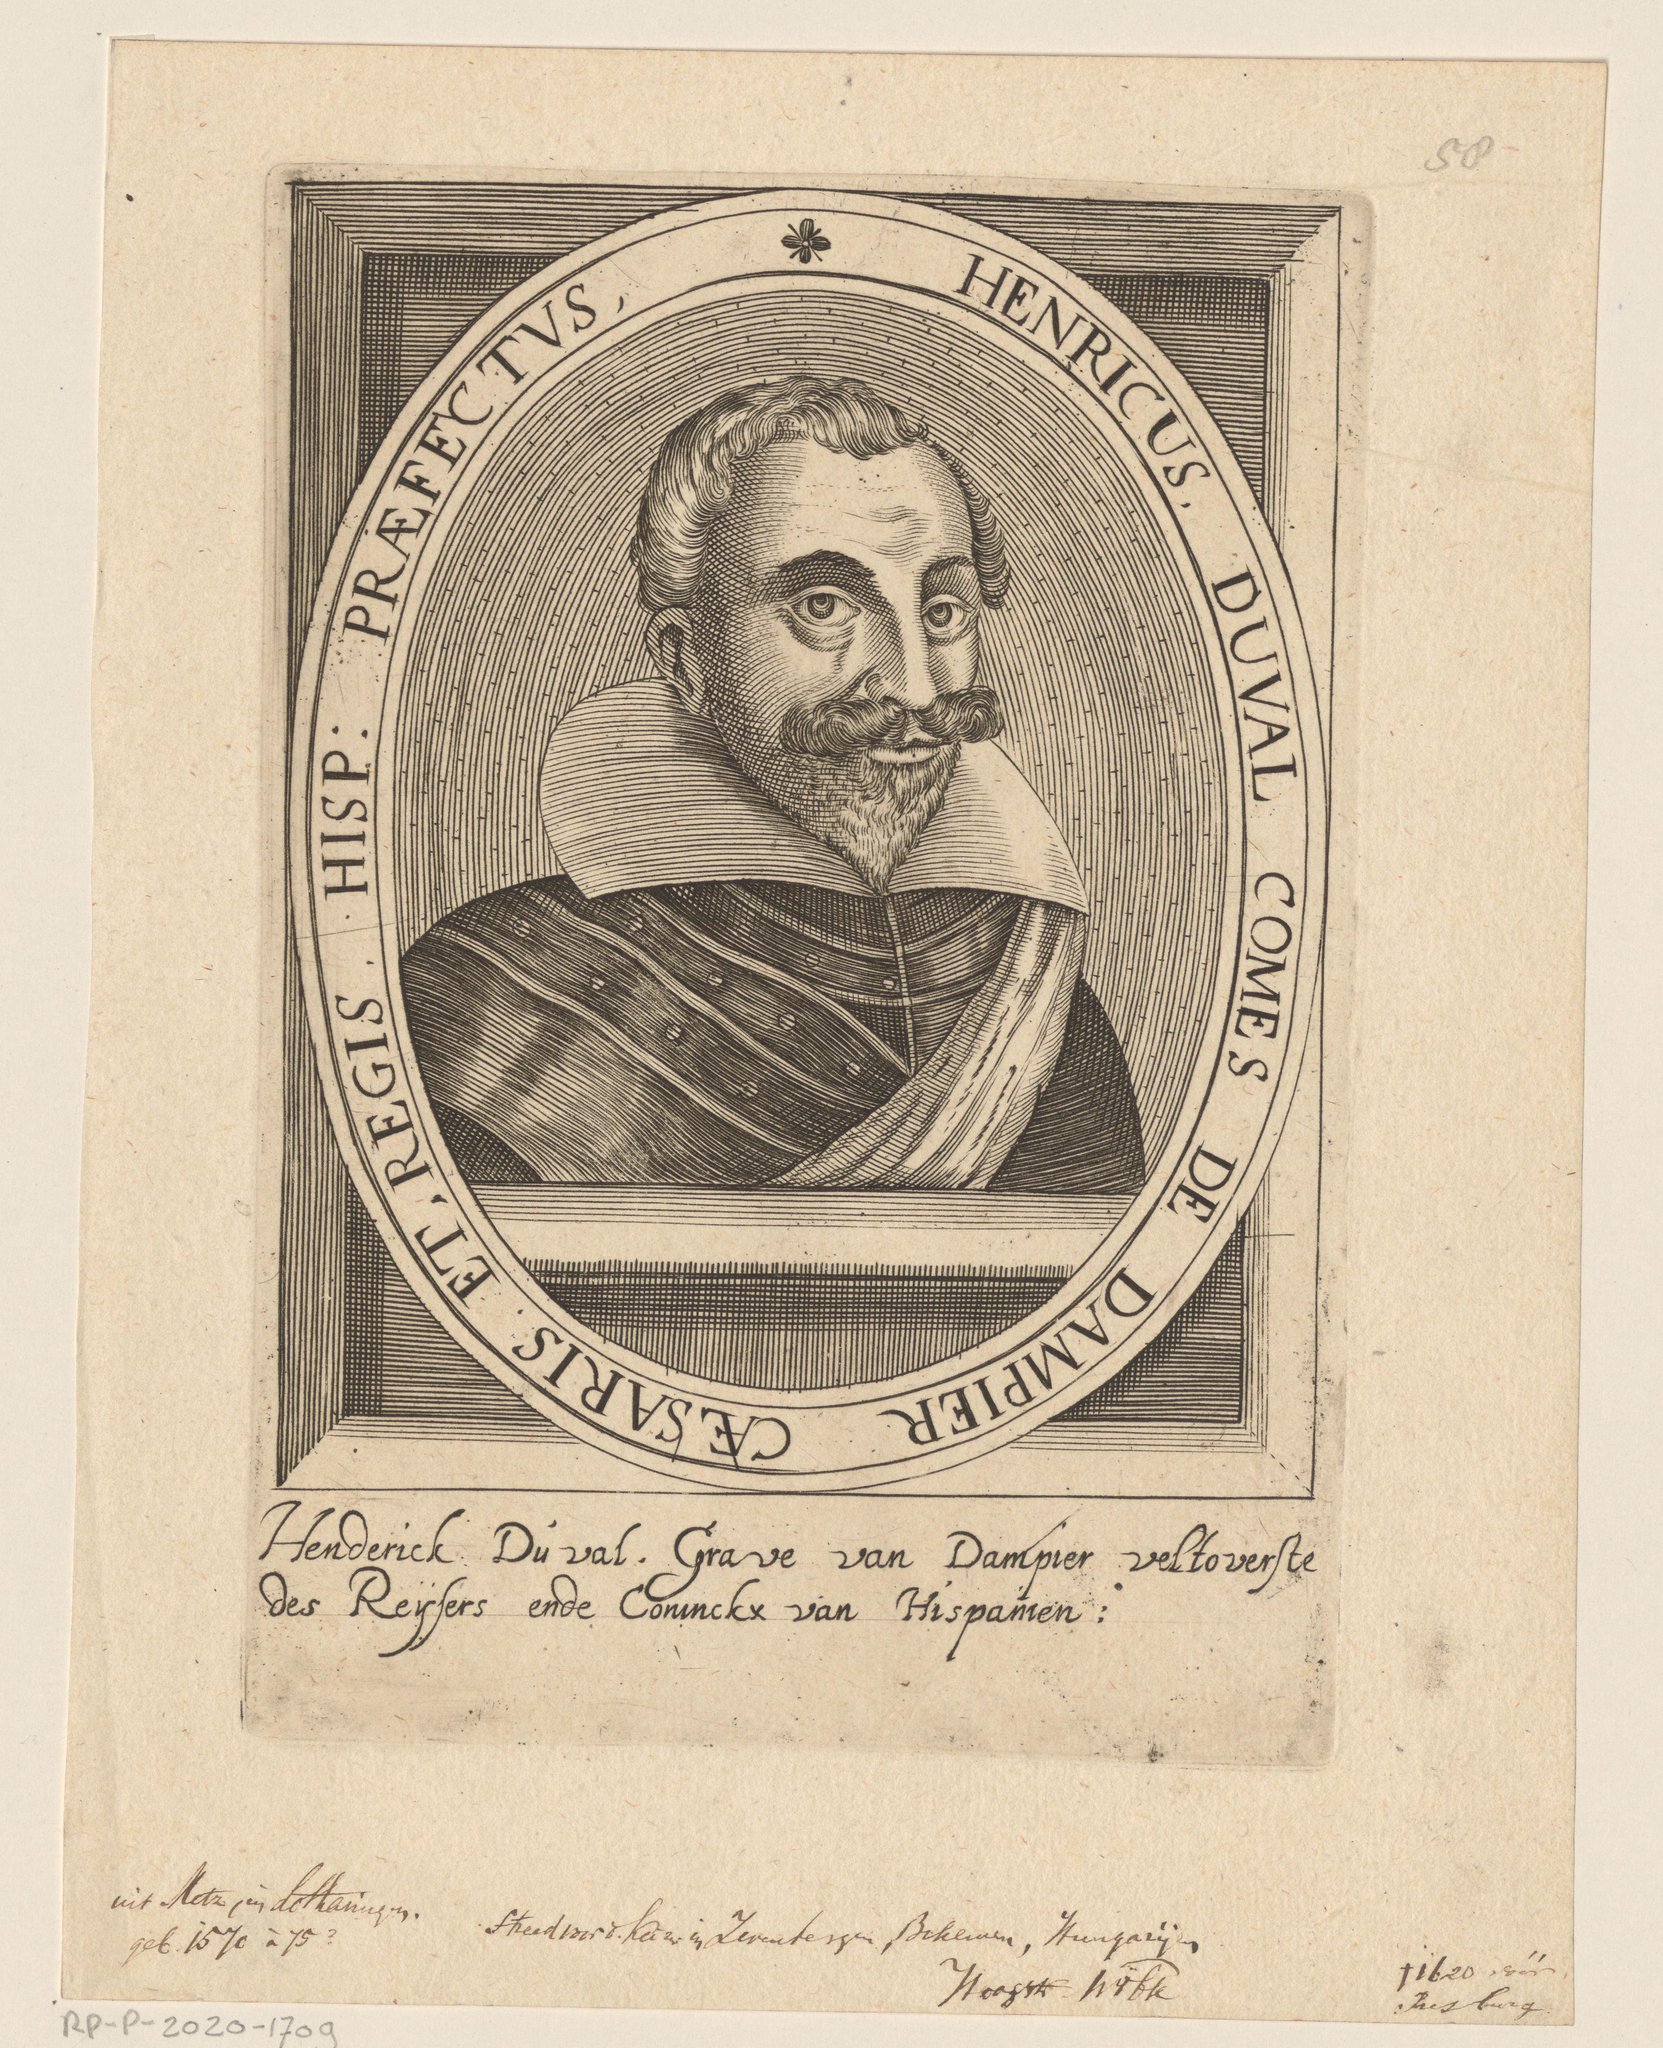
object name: print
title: Portret van Heinrich von Duval, graaf van Dampierre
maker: Anonymous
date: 1618-1699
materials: paper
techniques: engraving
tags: commander-in-chief, general, marshal, historical persons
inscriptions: inscription